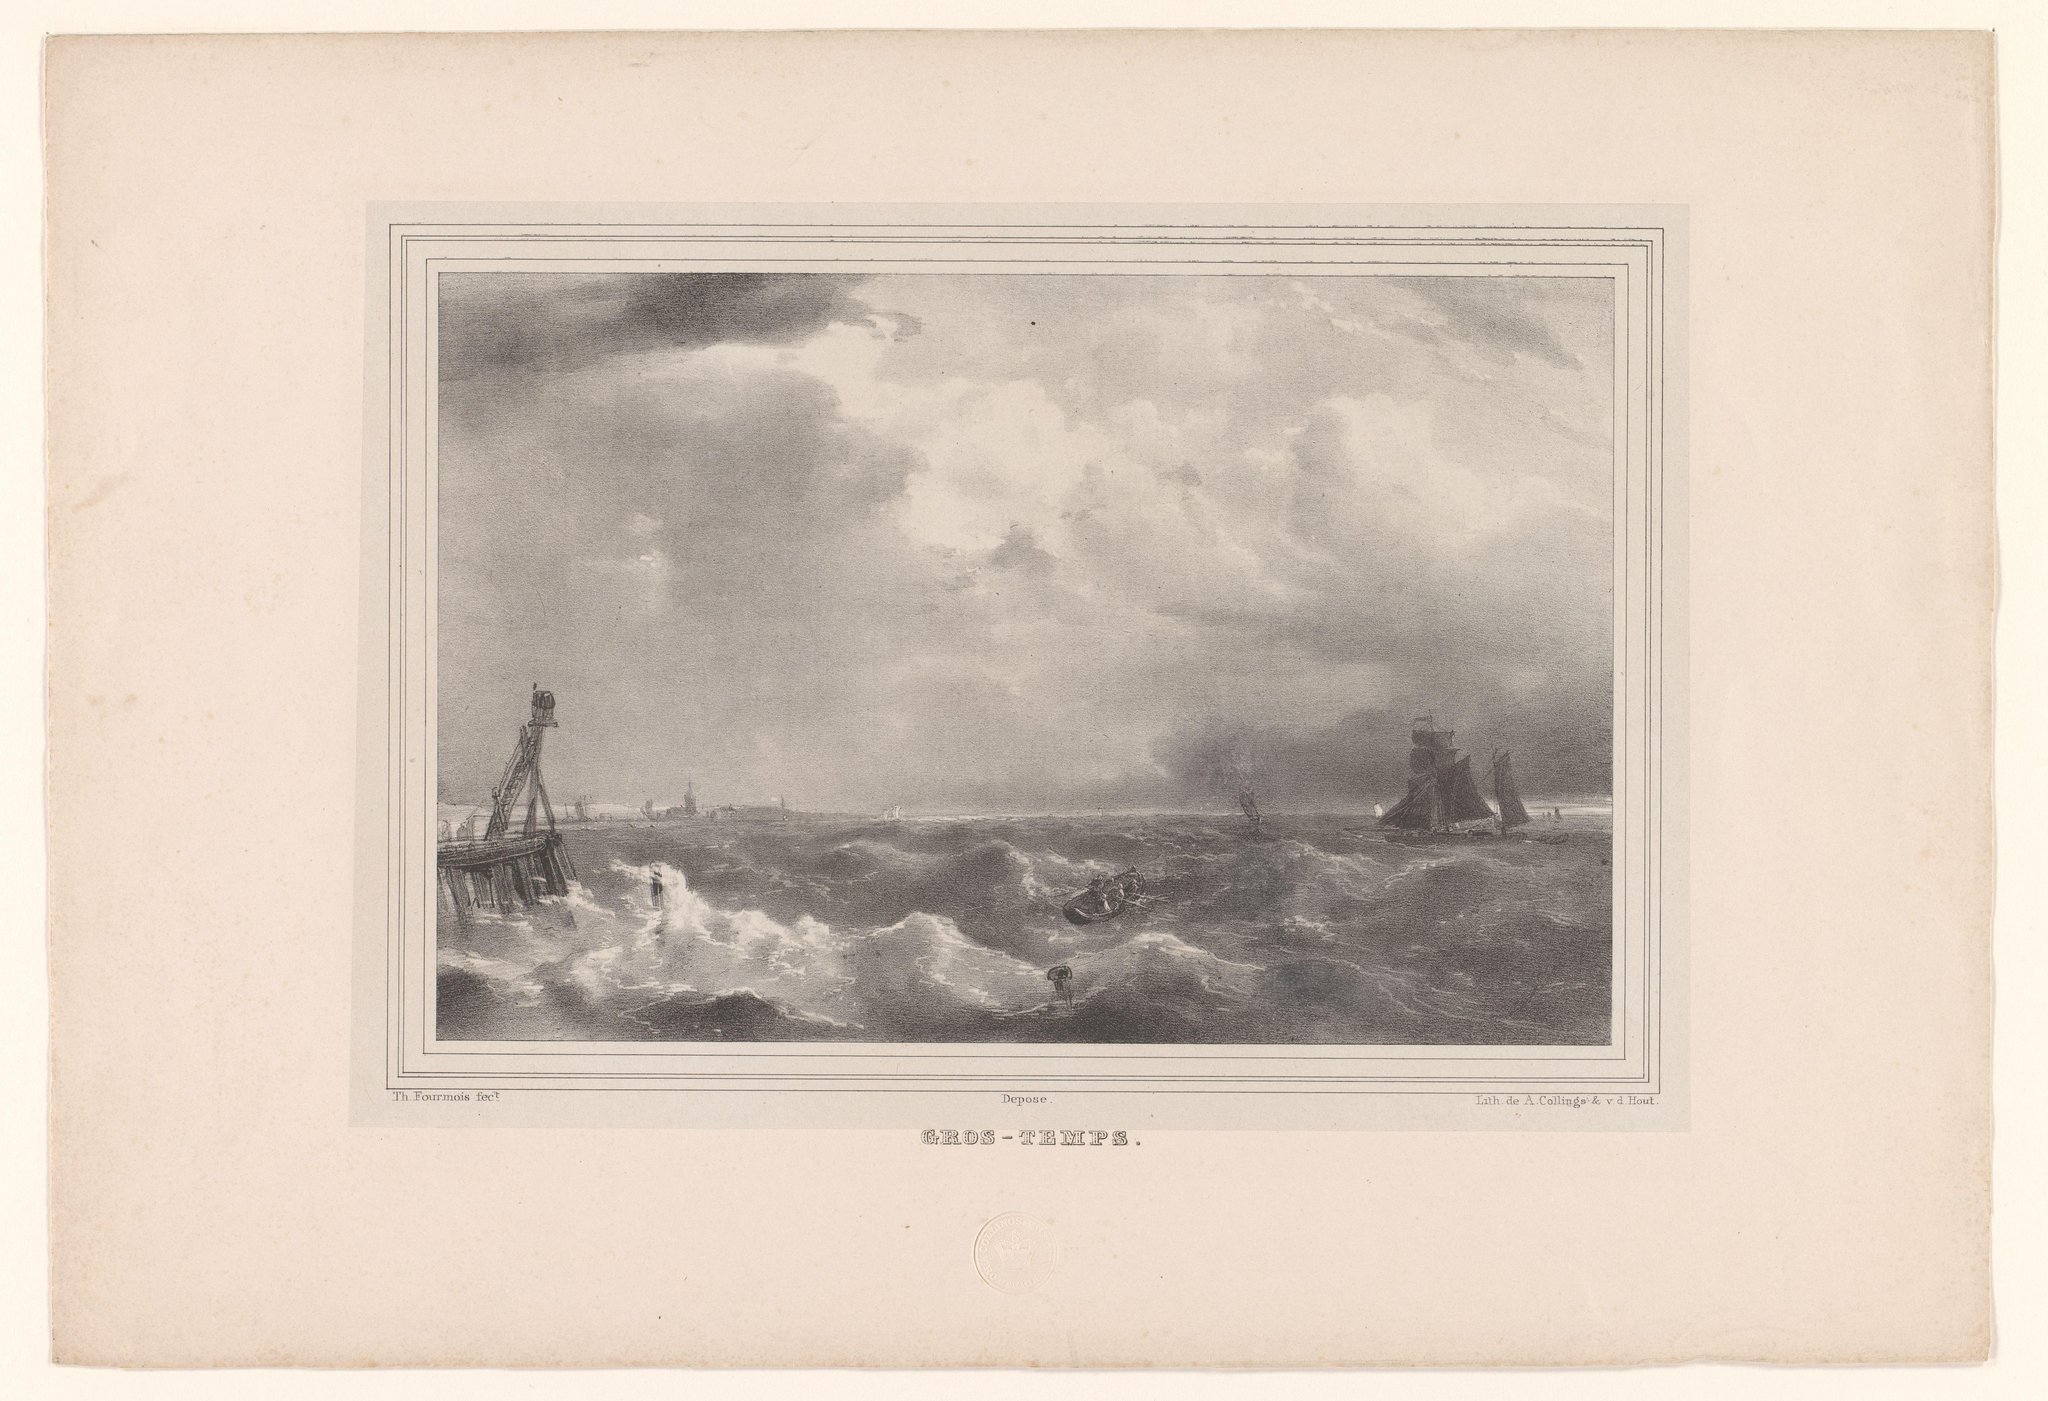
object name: print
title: Gezicht op een ruwe zee met schepen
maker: théodore fourmois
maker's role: print maker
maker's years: 1814-1871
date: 1836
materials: paper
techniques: lithograph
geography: rotterdam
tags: storm at sea, traffic on the water, netherlands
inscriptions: collector's mark: Lugt 2228, check stamp: ‘A. Collings & V.D. Hout, Rotterdam’, : ‘Depose’